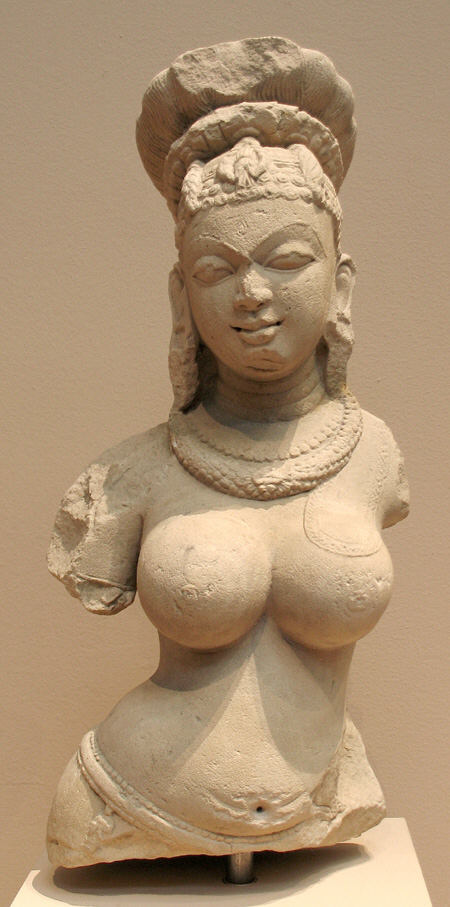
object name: bust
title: Bust of a Female Deity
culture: indian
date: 701-900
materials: stone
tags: female nudes,deities